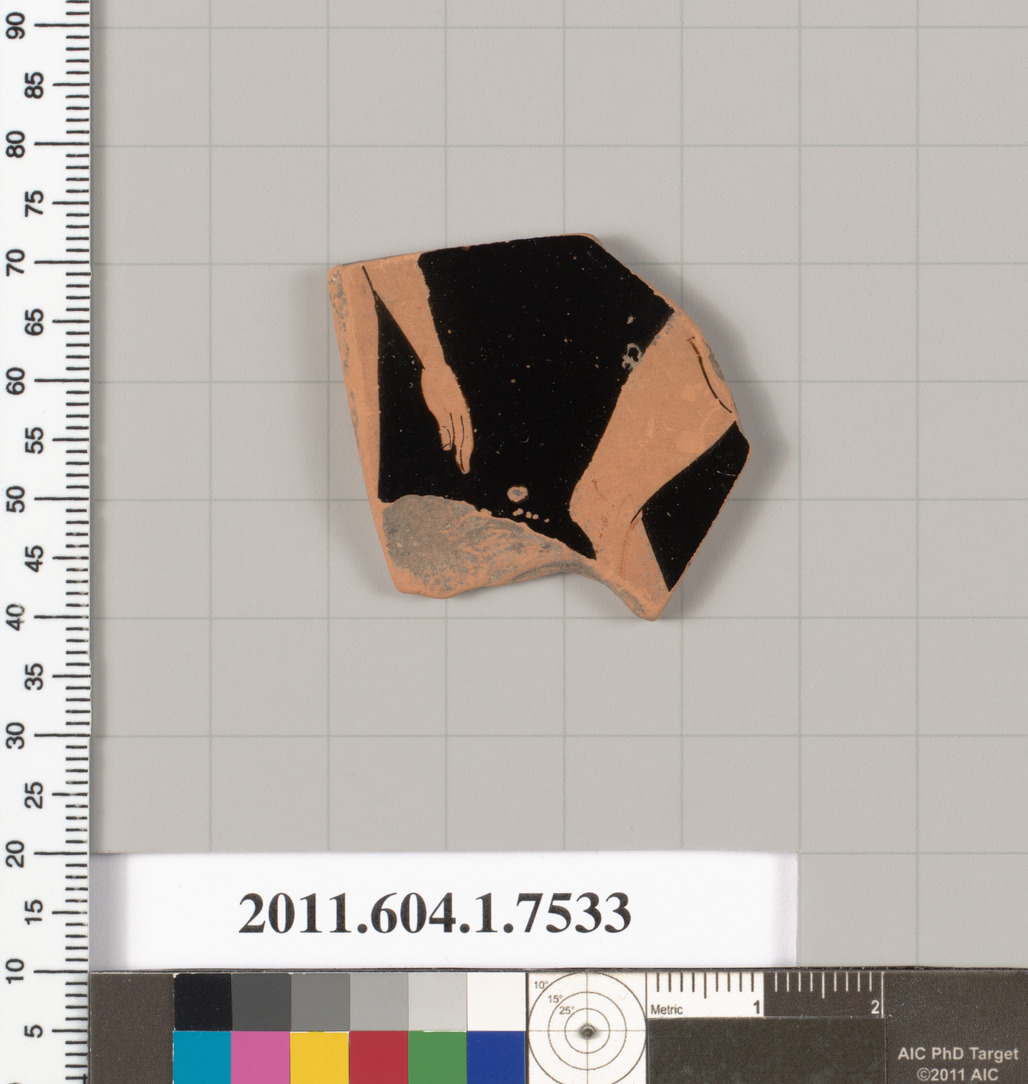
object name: kylix fragment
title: Terracotta fragment of a kylix (drinking cup)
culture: greek, attic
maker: euaion painter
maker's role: artist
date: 460-450 BCE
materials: terracotta